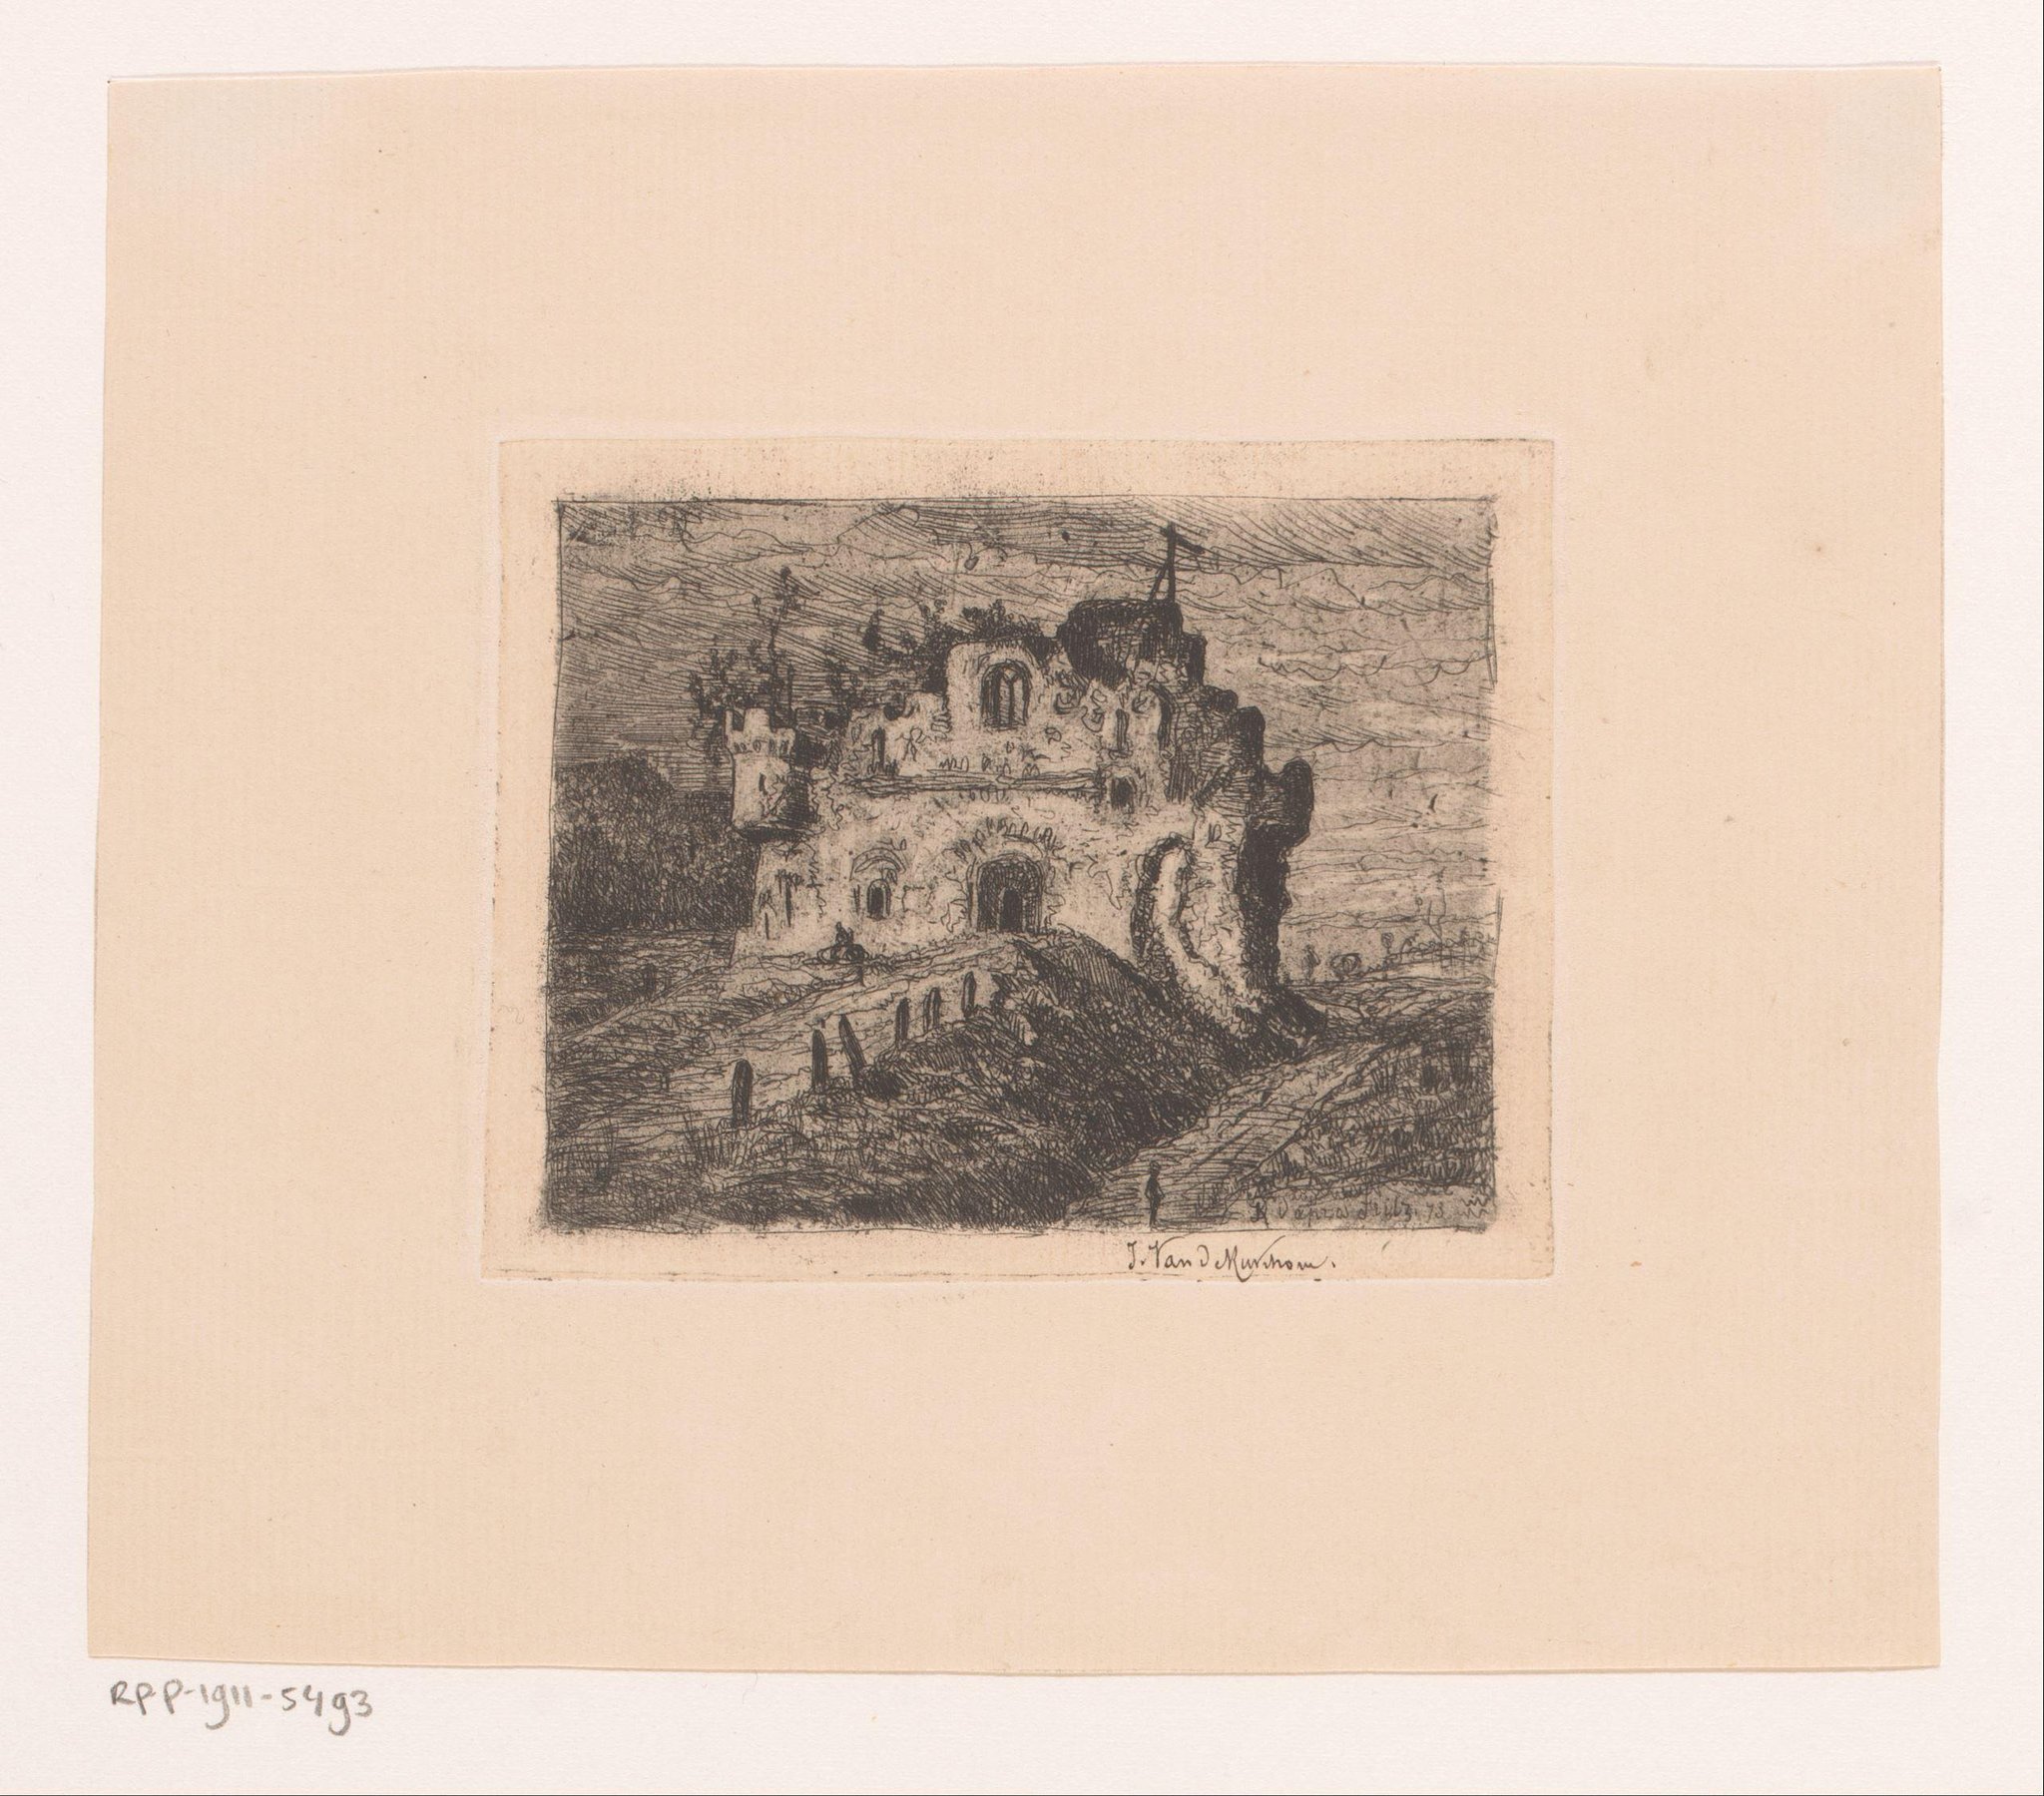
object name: print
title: Kasteelruïne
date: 1873-1881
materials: paper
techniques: etching, intaglio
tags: ruin of a dwelling, house, castle, etc.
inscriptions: collector's mark: Lugt 2228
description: De etsen naar de schilderijen van Frédéric Van de Kerkhove werden na zijn dood door zijn vader en zuster gemaakt en uitgegeven in twee reeksen. De eerste werd in 1877 uitgegeven door het Journal des Beaux-Arts et de la Littérature: Cahier de 25 Eaux-fortes d'après Frédéric van de Kerkhove, gravées par son père et sa sœur. De tweede reeks van 126 etsen, ook in 1877, werd in Parijs uitgegeven bij A. Lévy onder de titel Cent eaux-fortes gravées par J. Van de Kerkhove d'après les tableaux de Frédéric Van de Kerkhove, mort en 1873 à l'âge de 10 ans et 11 mois.